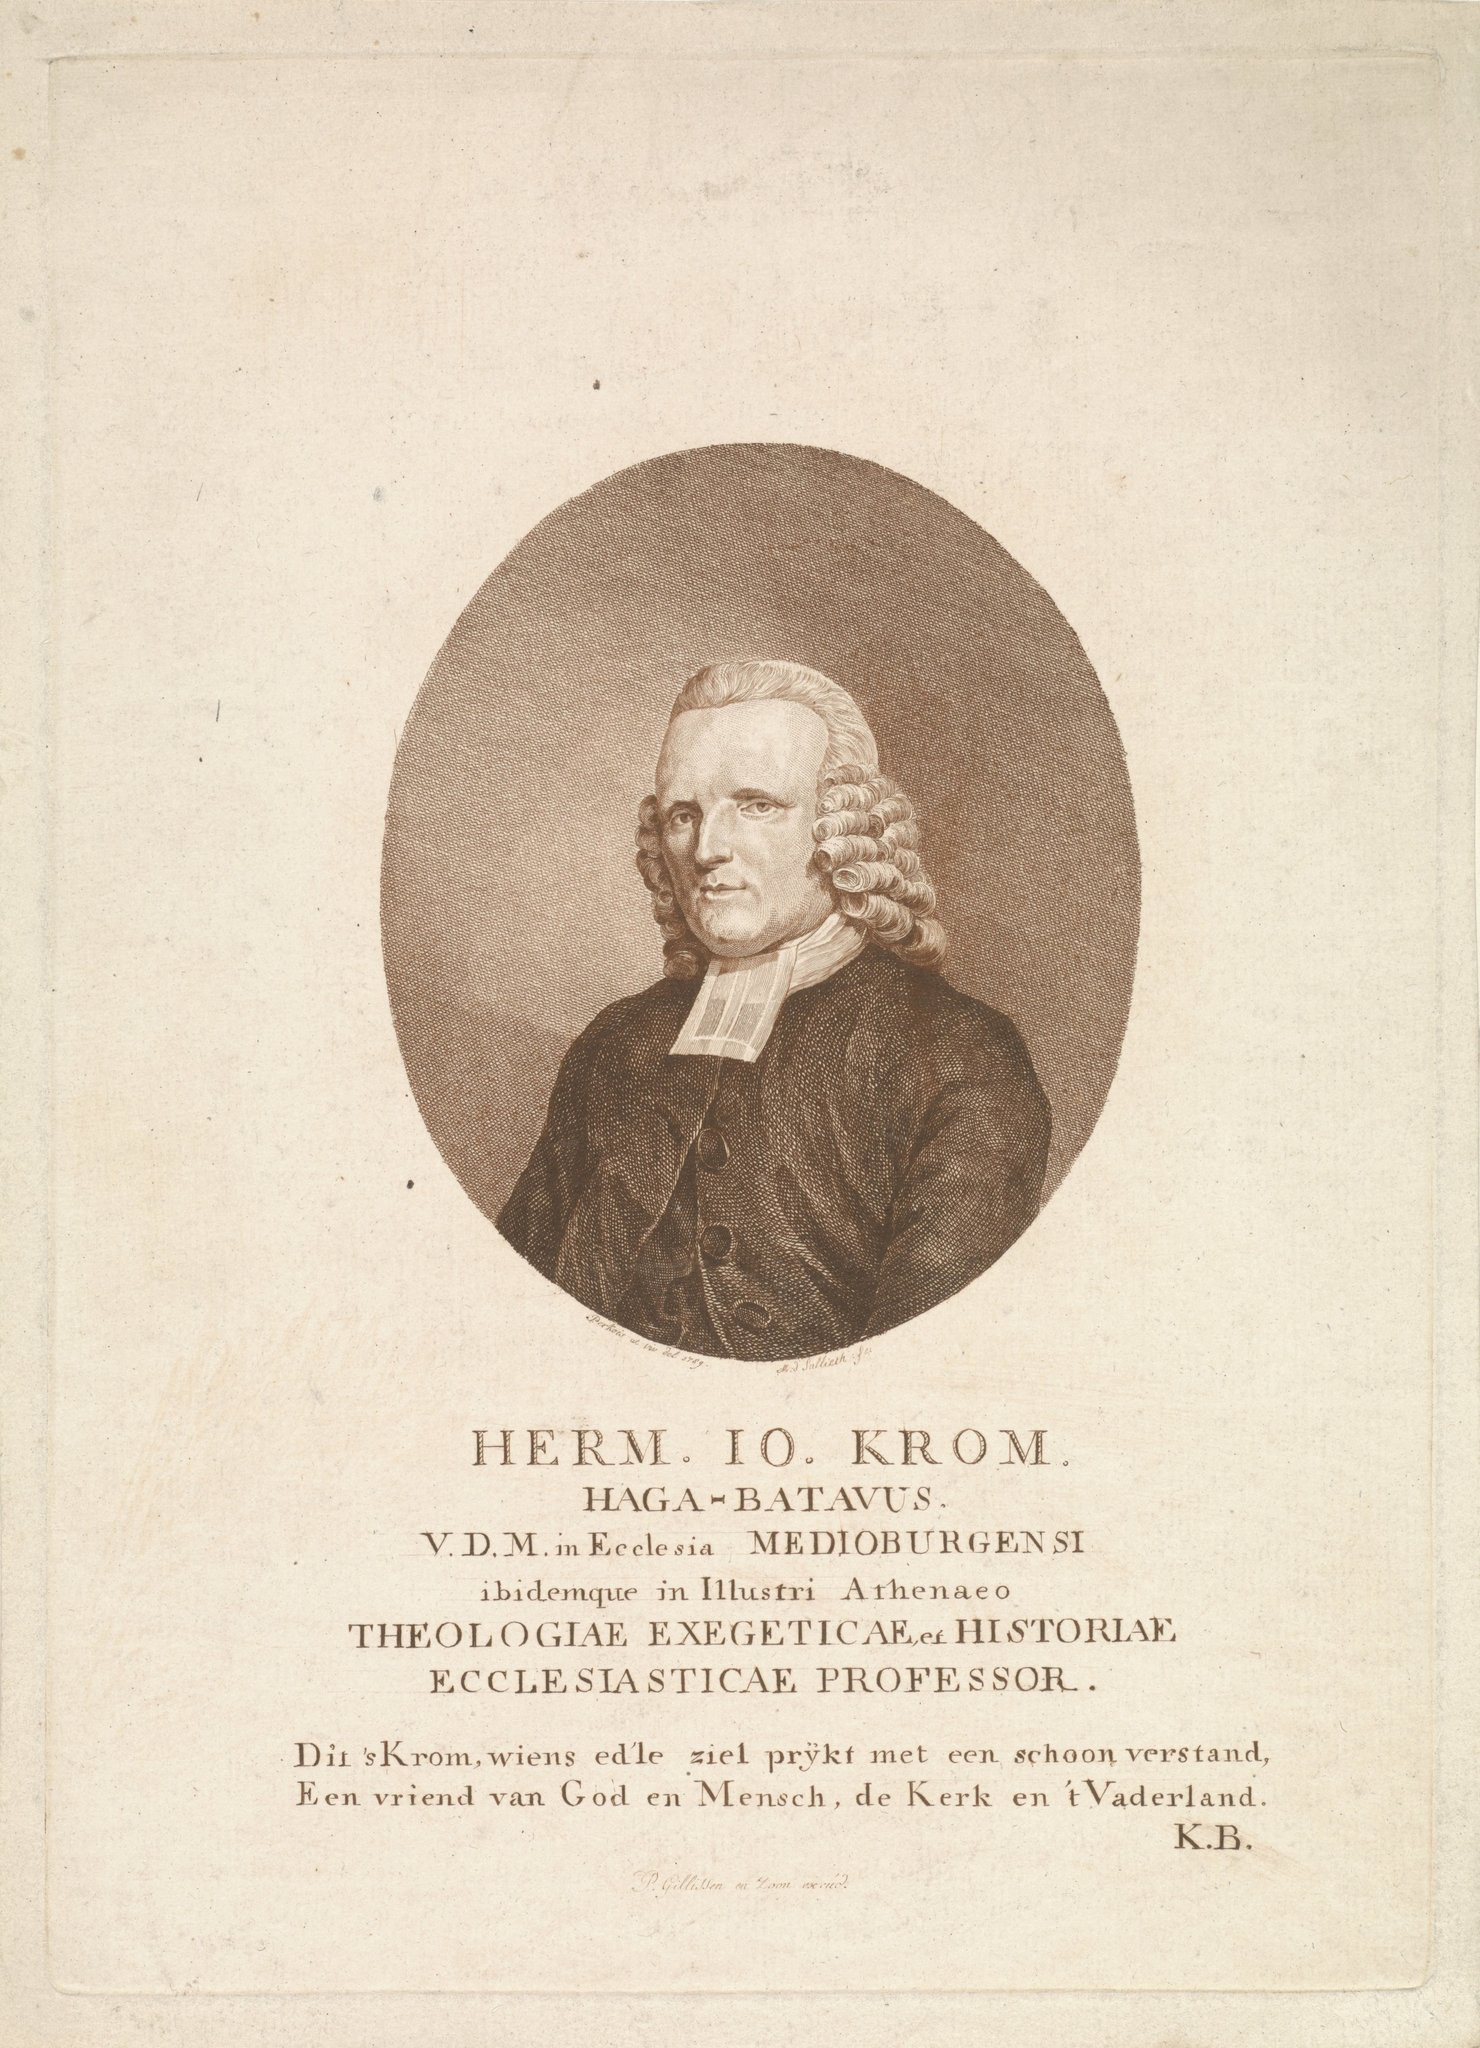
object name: print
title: Portret van Hermanus Johannes Krom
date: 1789-1790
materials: paper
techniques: engraving, etching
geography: middelburg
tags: the hague, middelburg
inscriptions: collector's mark: Lugt 2228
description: Portret van Hermanus Johannes Krom, predikant te Middelburg en hoogleraar kerkgeschiedenis.